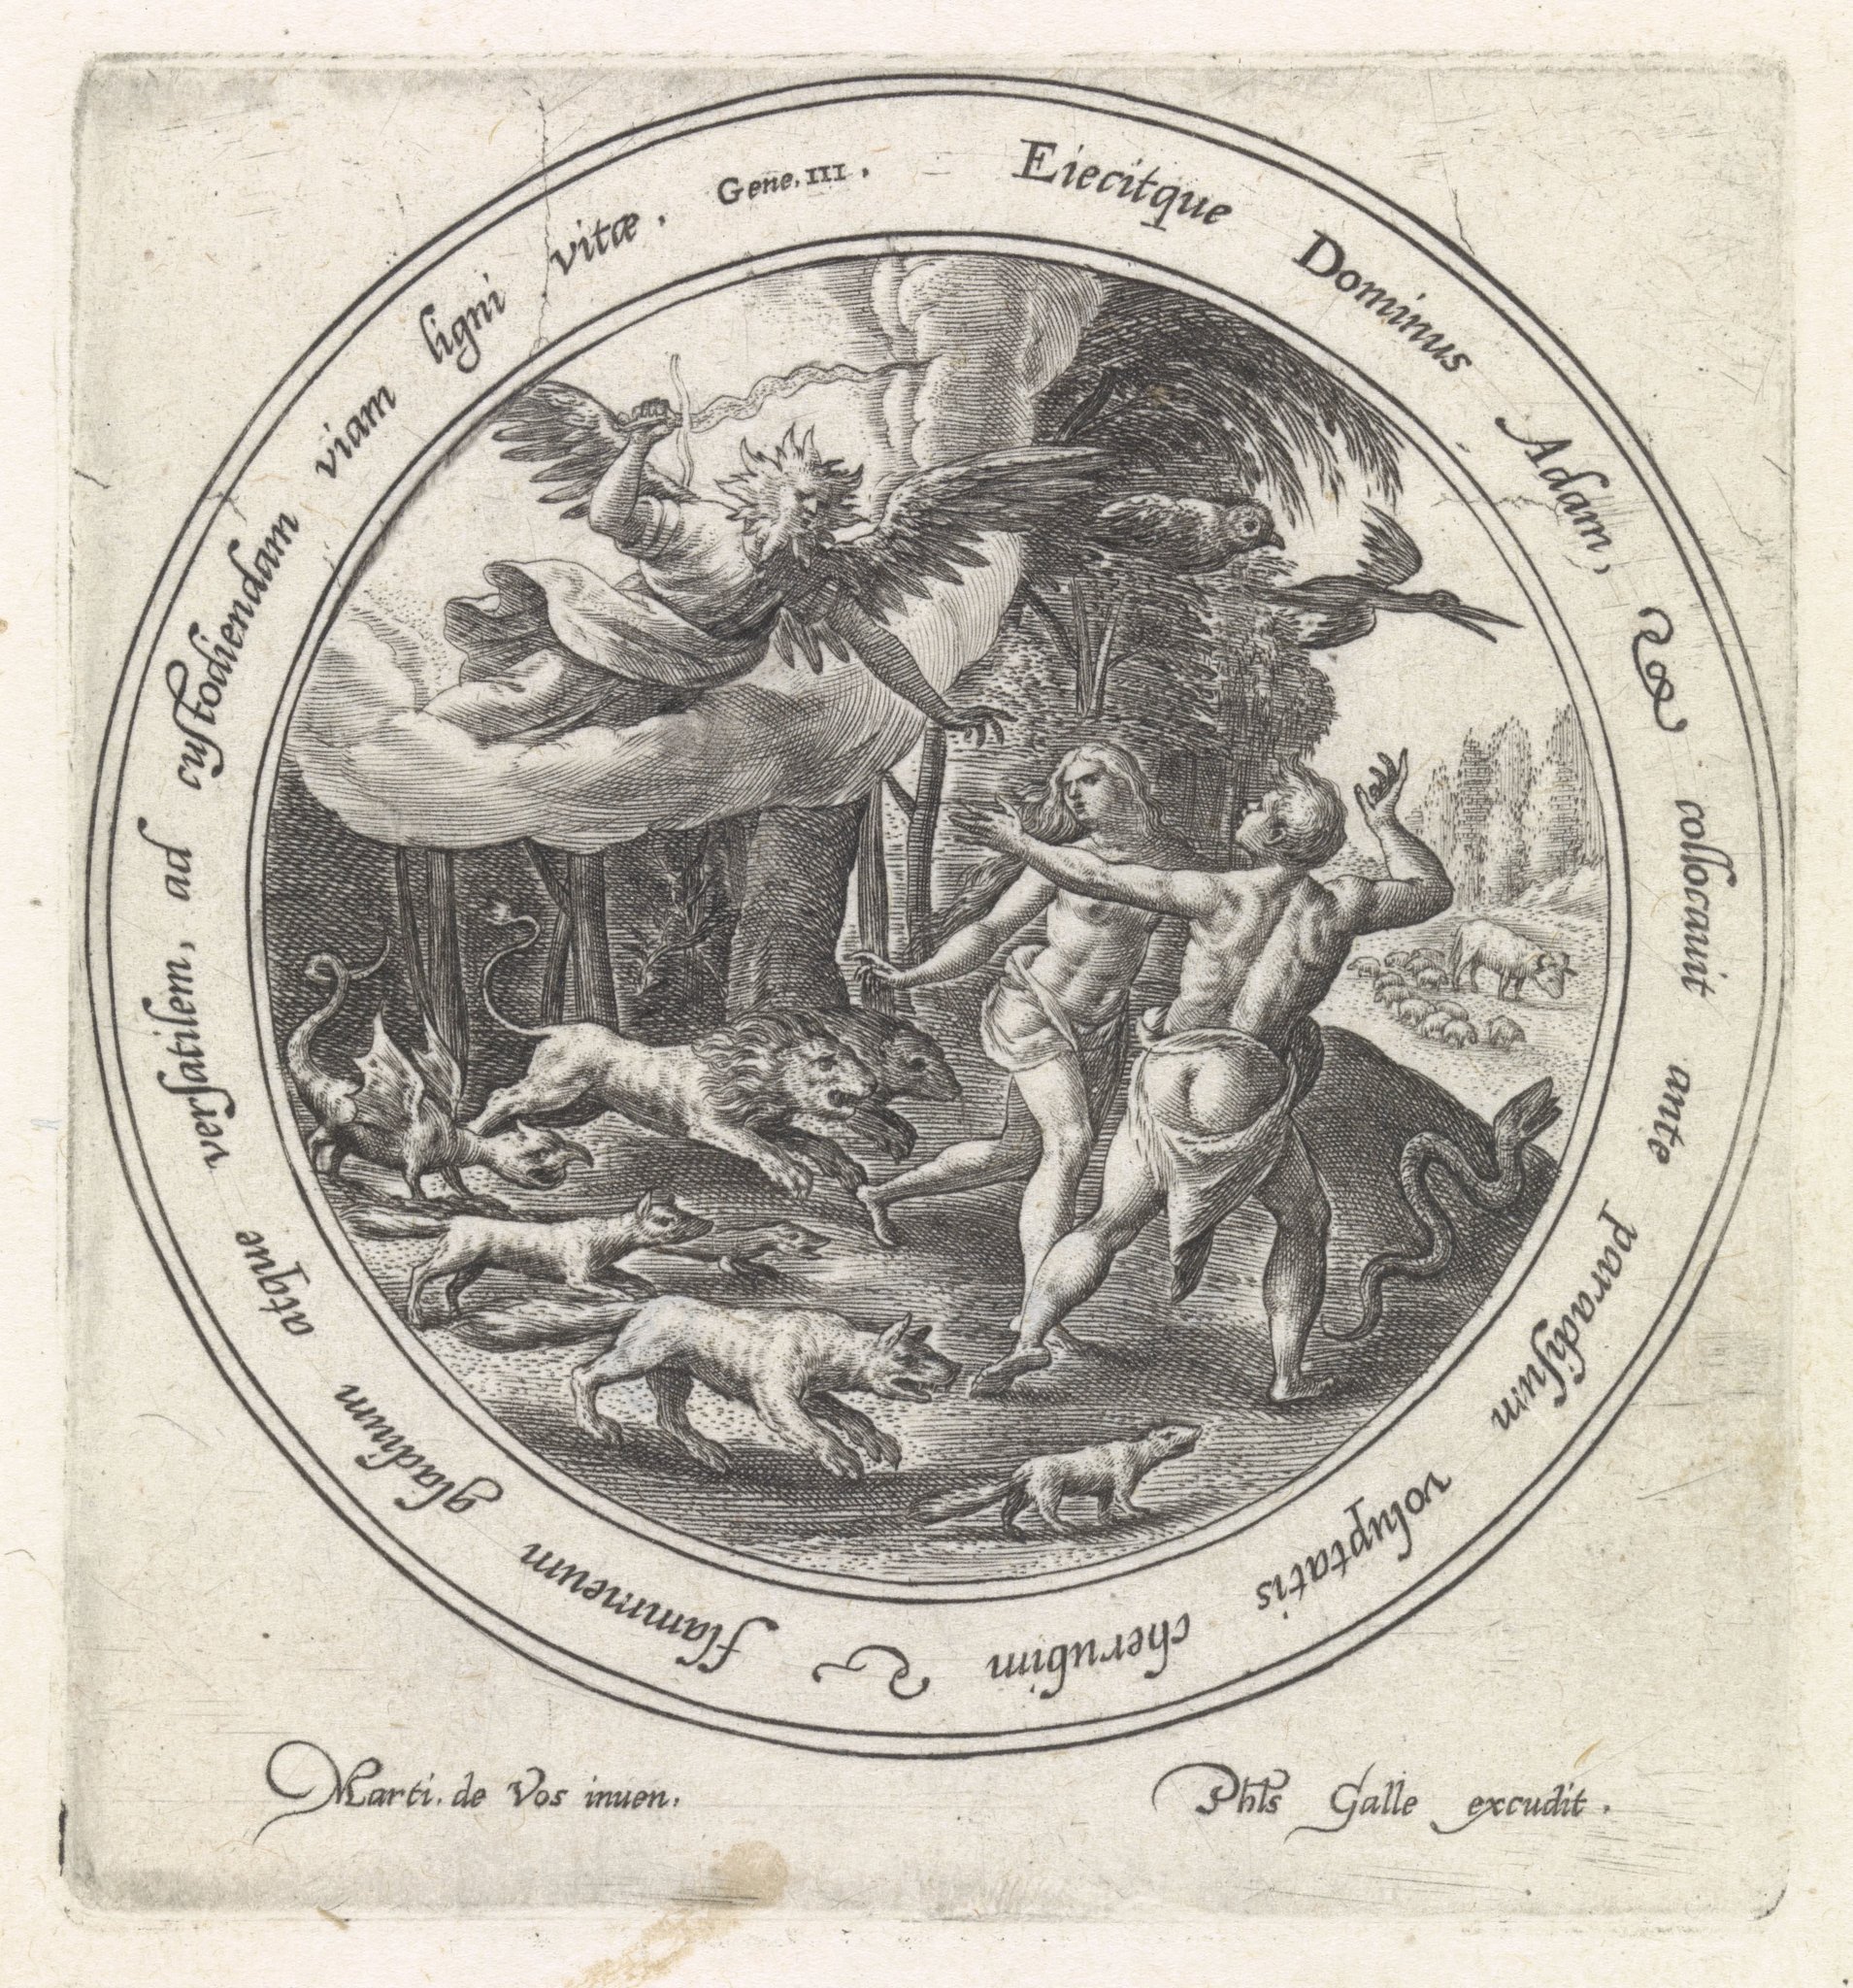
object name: print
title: Expulsion from Paradise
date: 1580-1588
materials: paper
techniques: engraving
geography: antwerp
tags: an angel chases adam and eve out of paradise with a (flaming) sword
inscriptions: collector's mark: Lugt 2760, collector's mark: Lugt 2228, number: ‘6’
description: De engel verdrijft Adam en Eva met zijn zwaard uit het paradijs. God overhandigde Adam en Eva kleren van dierenhuiden, om hun naaktheid te bedekken. In het randschrift van de omlijsting een Bijbelcitaat uit Gen. in het Latijn.